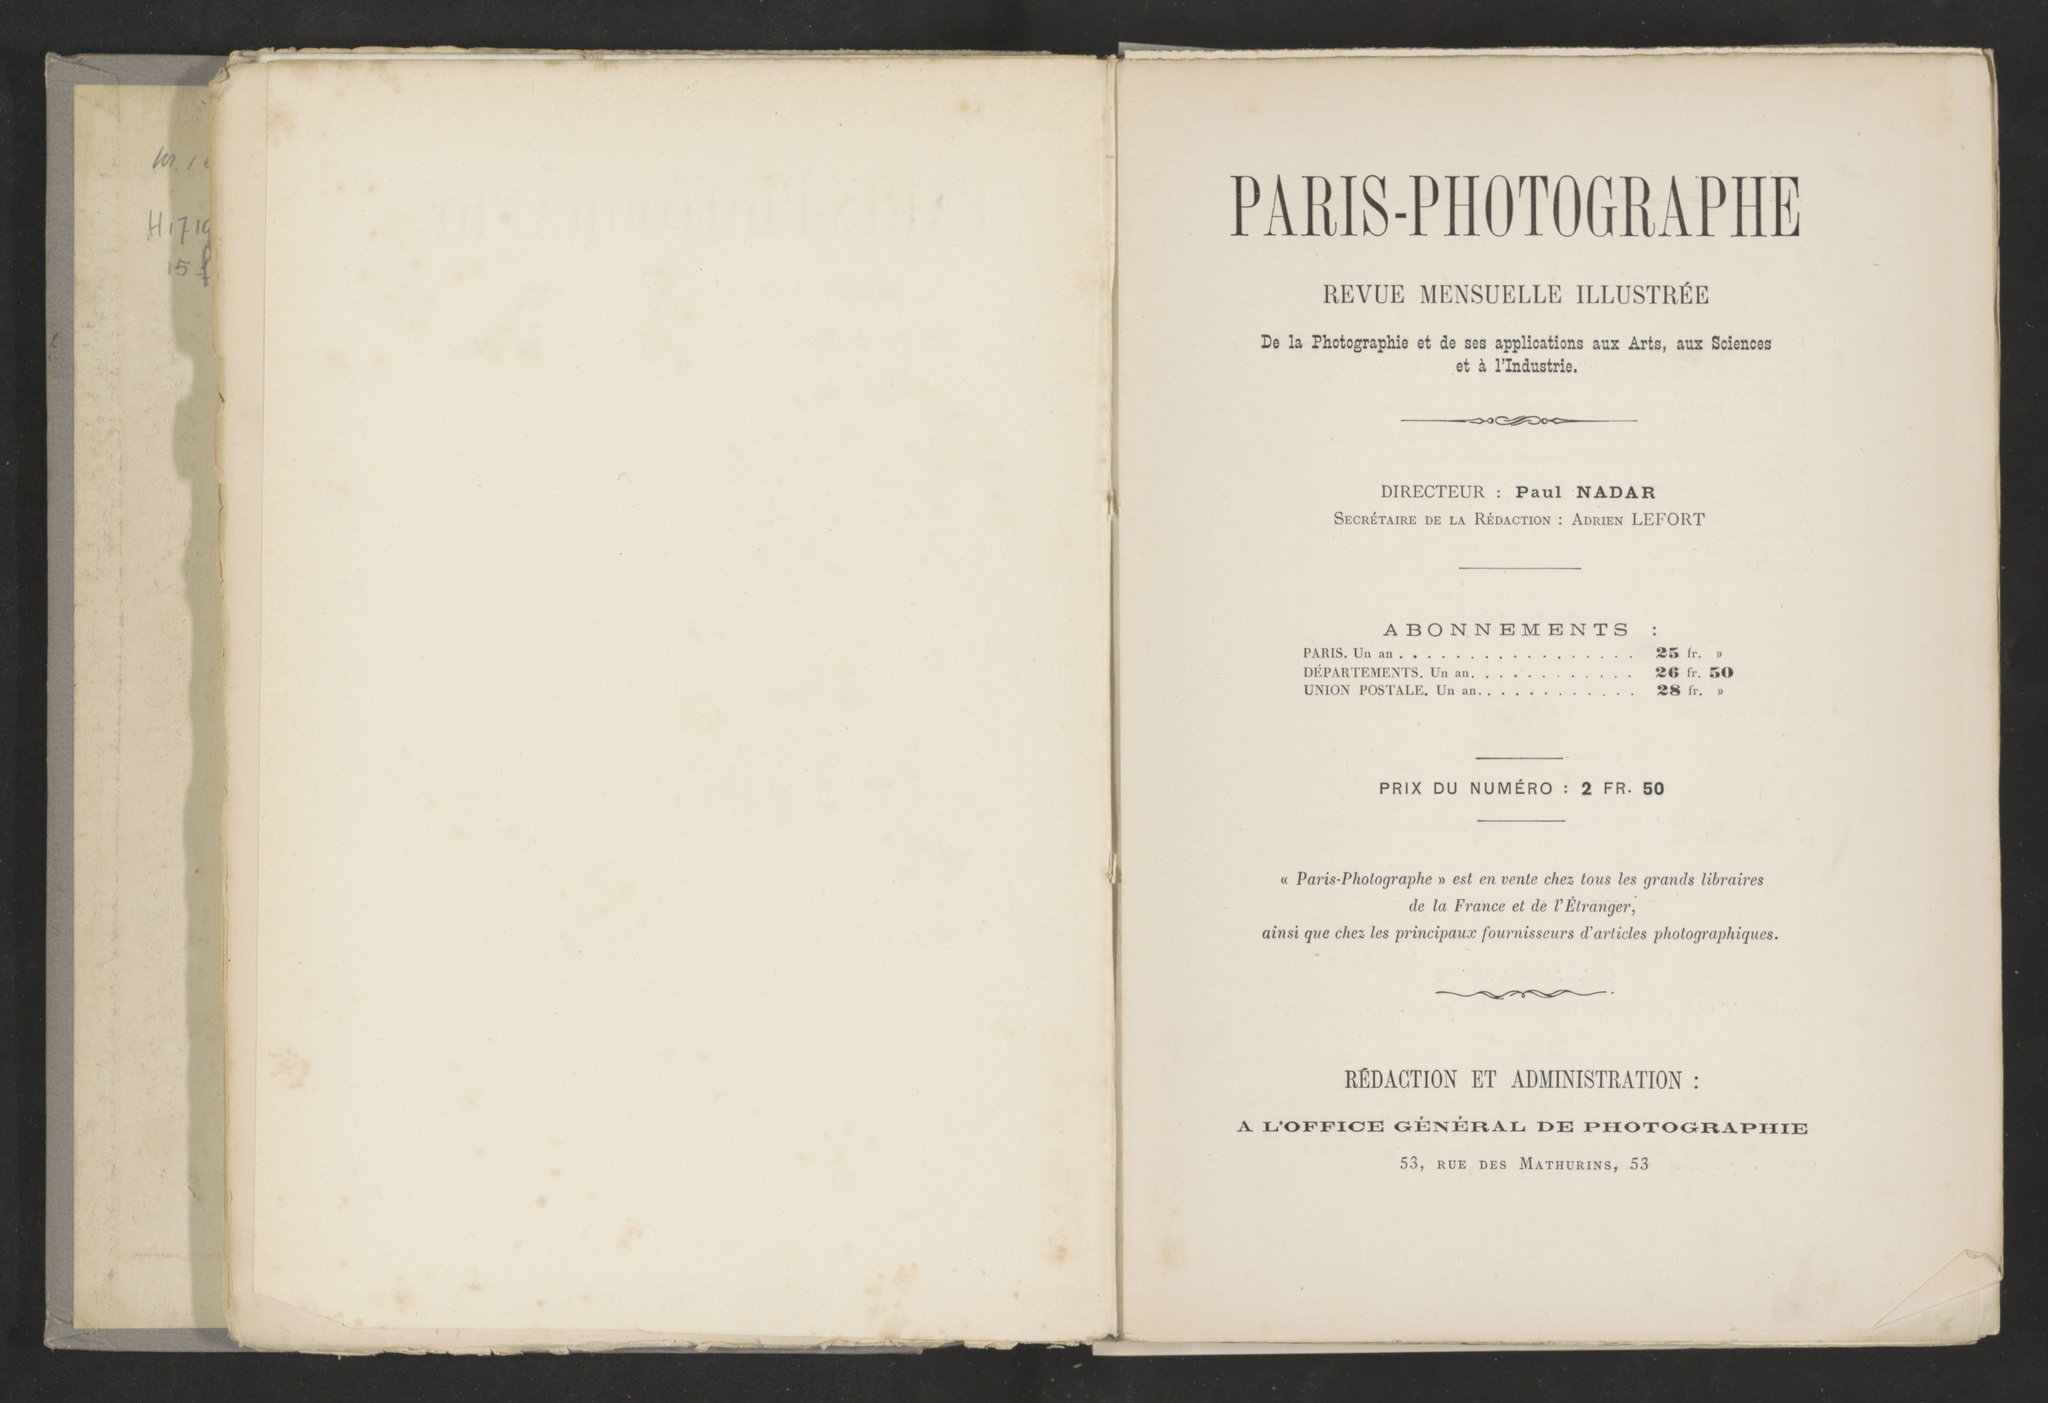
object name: magazine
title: Paris-Photographe première année 1891 No 4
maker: paul nadar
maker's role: fotograaf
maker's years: 1856-1939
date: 1891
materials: paper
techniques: engraving, printing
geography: paris